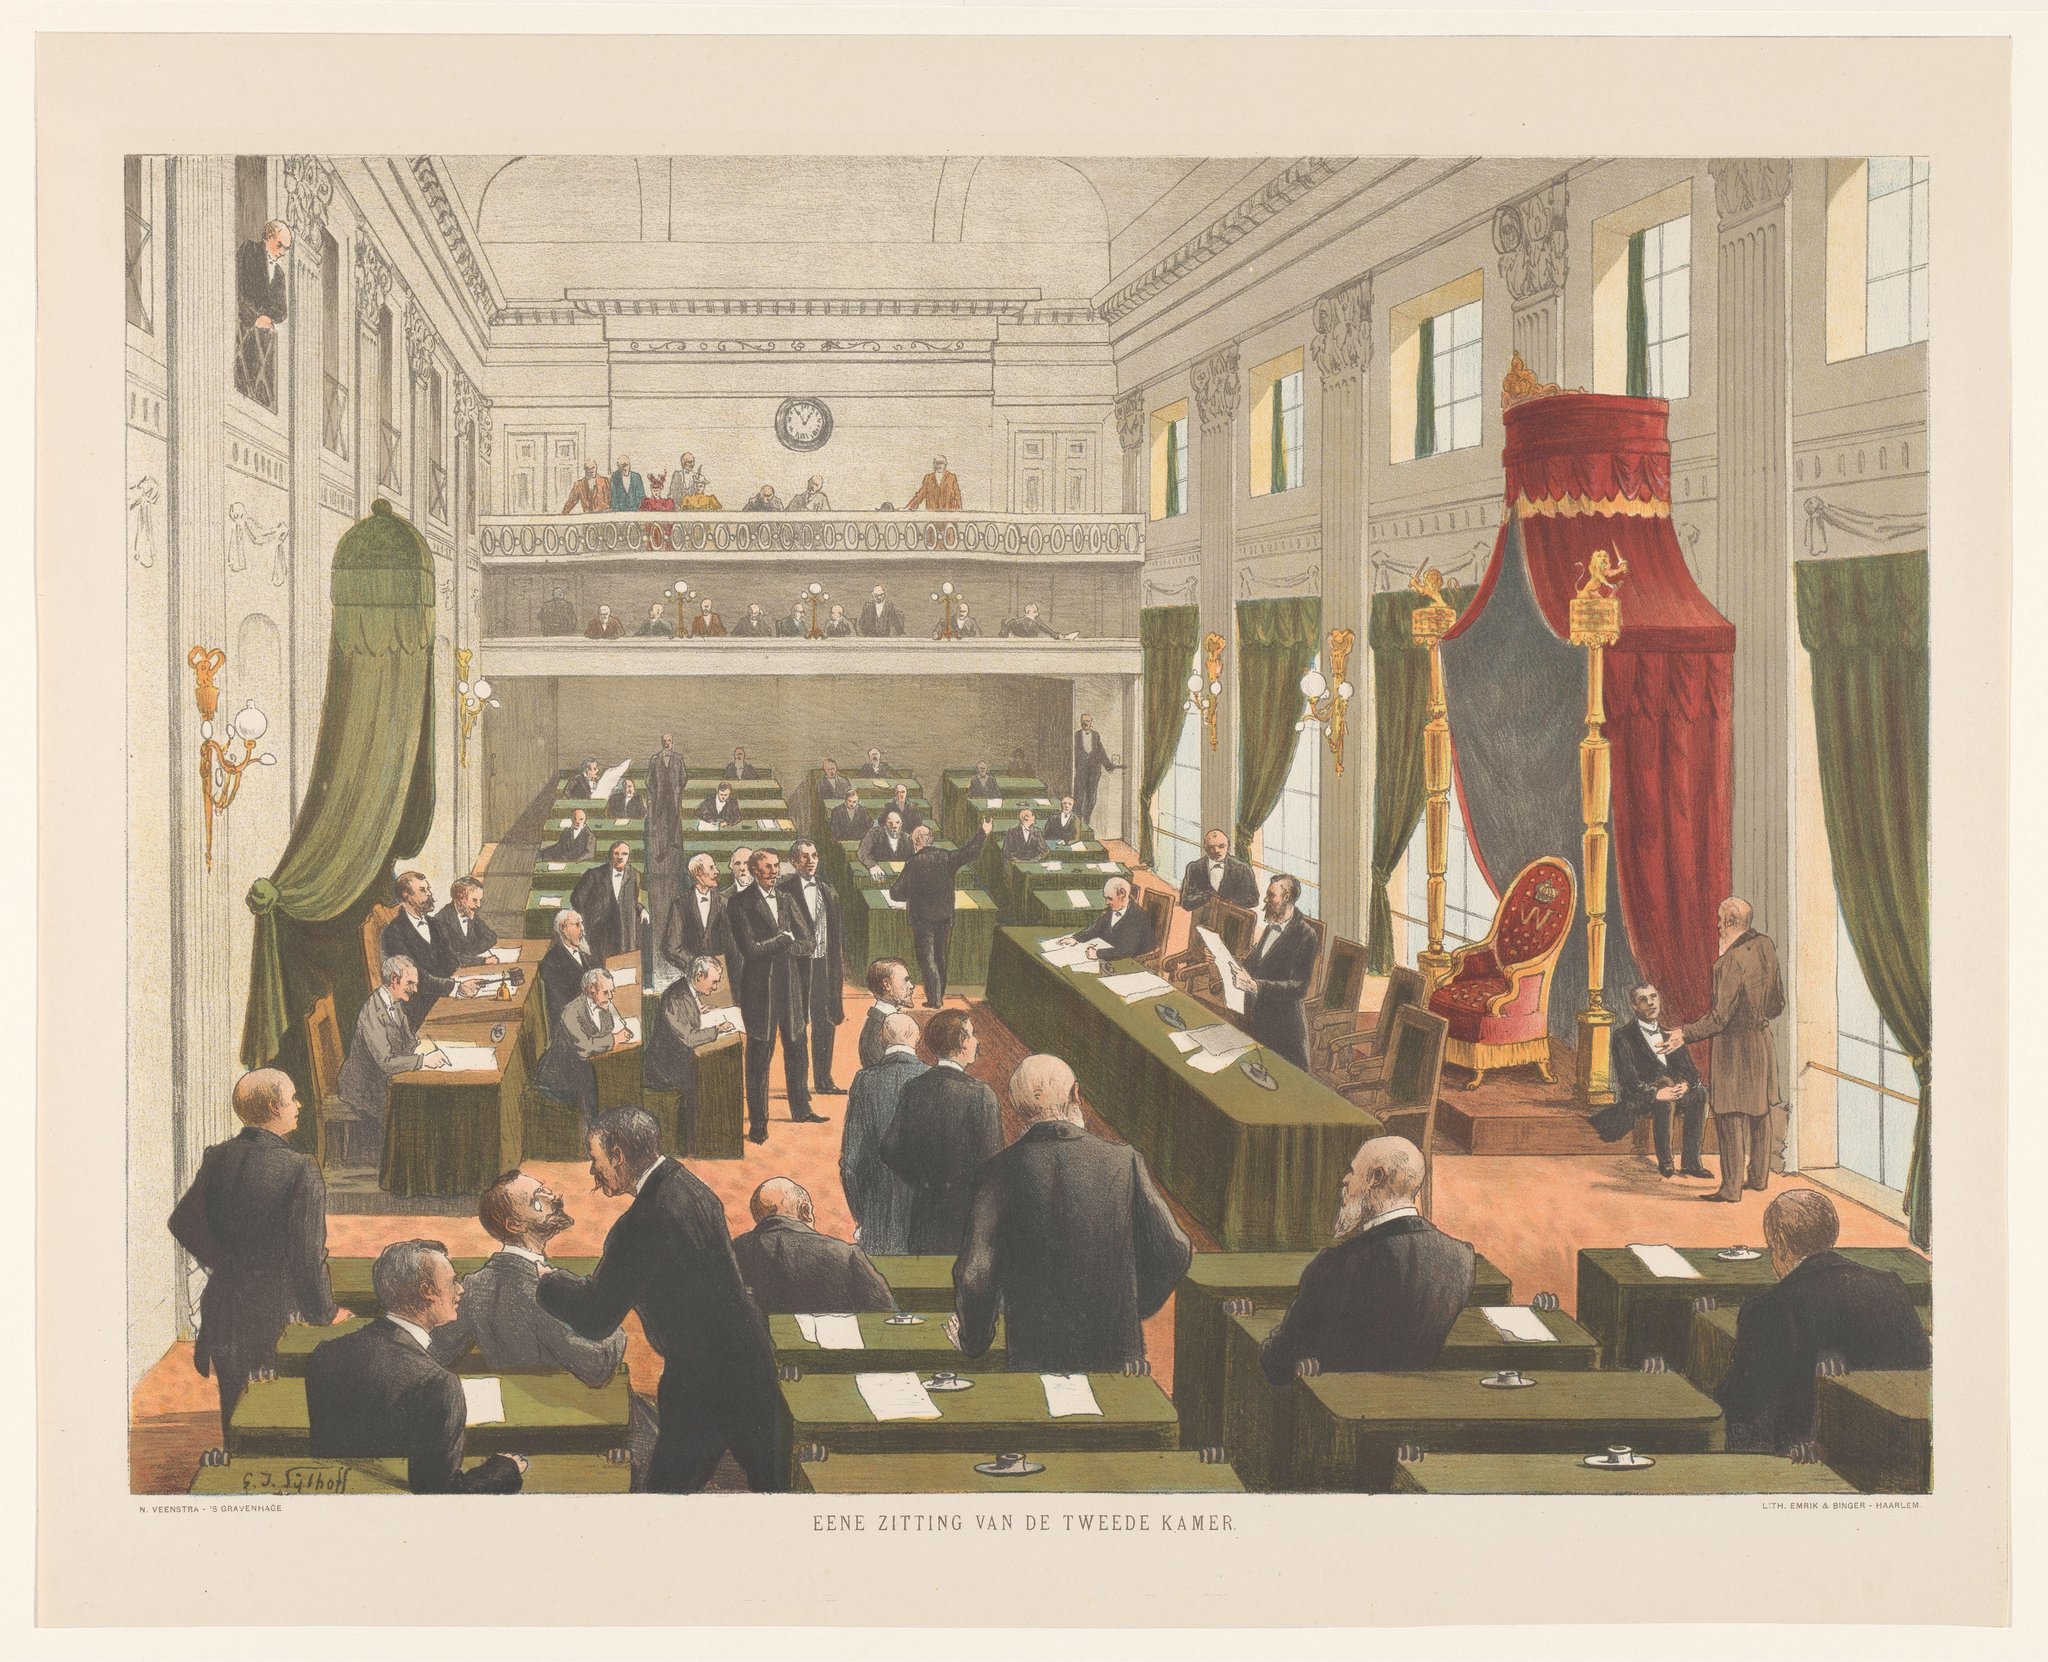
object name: schoolplaat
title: Eene zitting van de Tweede Kamer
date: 1900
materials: paper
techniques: lithograph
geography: haarlem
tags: debate, discussion (~ parliament)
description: Interieur van de Tweede Kamer der Staten Generaal (Binnenhof te Den Haag) met verscheidene Mannen (kamerleden in zwarte en grijze kostuums. Meubels en gordijnen. Rechts troon met W en baldakijn daarboven in rood en goud. Aan het einde van de zaal publieke tribune met toebehoorders.